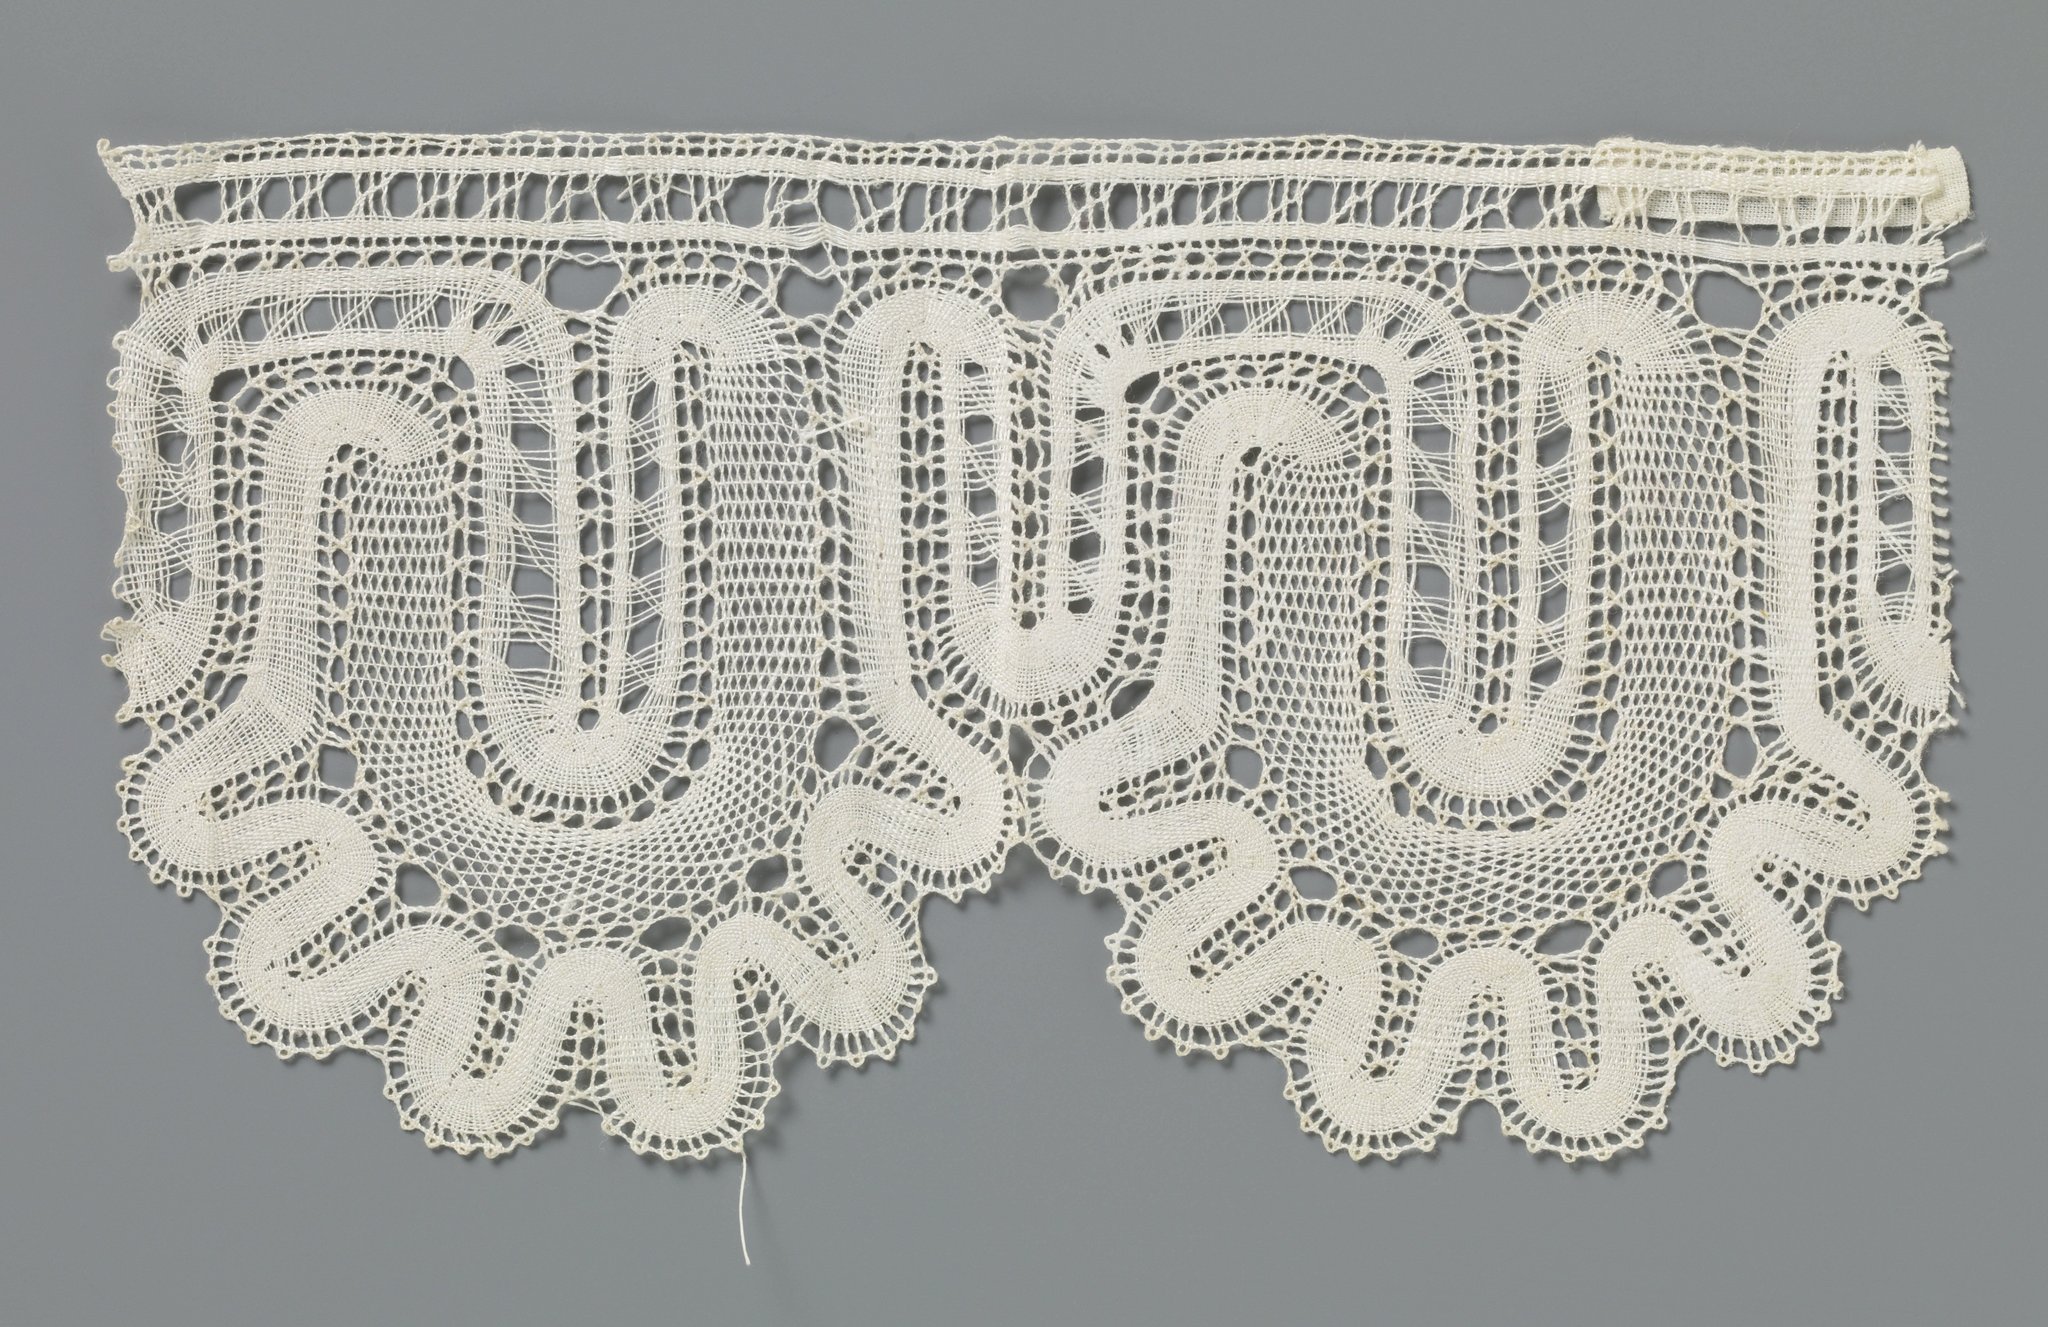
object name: strip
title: Strook kloskant met gevarieerd lint dat u-vormige schulp vormt met zes lobben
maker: Anonymous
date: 1900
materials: linen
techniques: lace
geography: russia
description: Strook naturelkleurige kloskant, Russische kant. Het zich herhalende patroon wordt gevormd door een lint dat al slingerend een u-vormige schulp vormt met zes lobben aan de onderzijde. Het lint is gemaakt in drie in elkaar overlopende variaties aan slagen, allen met opengewerkte randjes: netslag, dichtgewerkte linnenslag en linnenslag met een opengewerkt centrum waarin overstekende paren blokjes met diagonale lijnen vormen. De bovenzijde is recht afgewerkt.